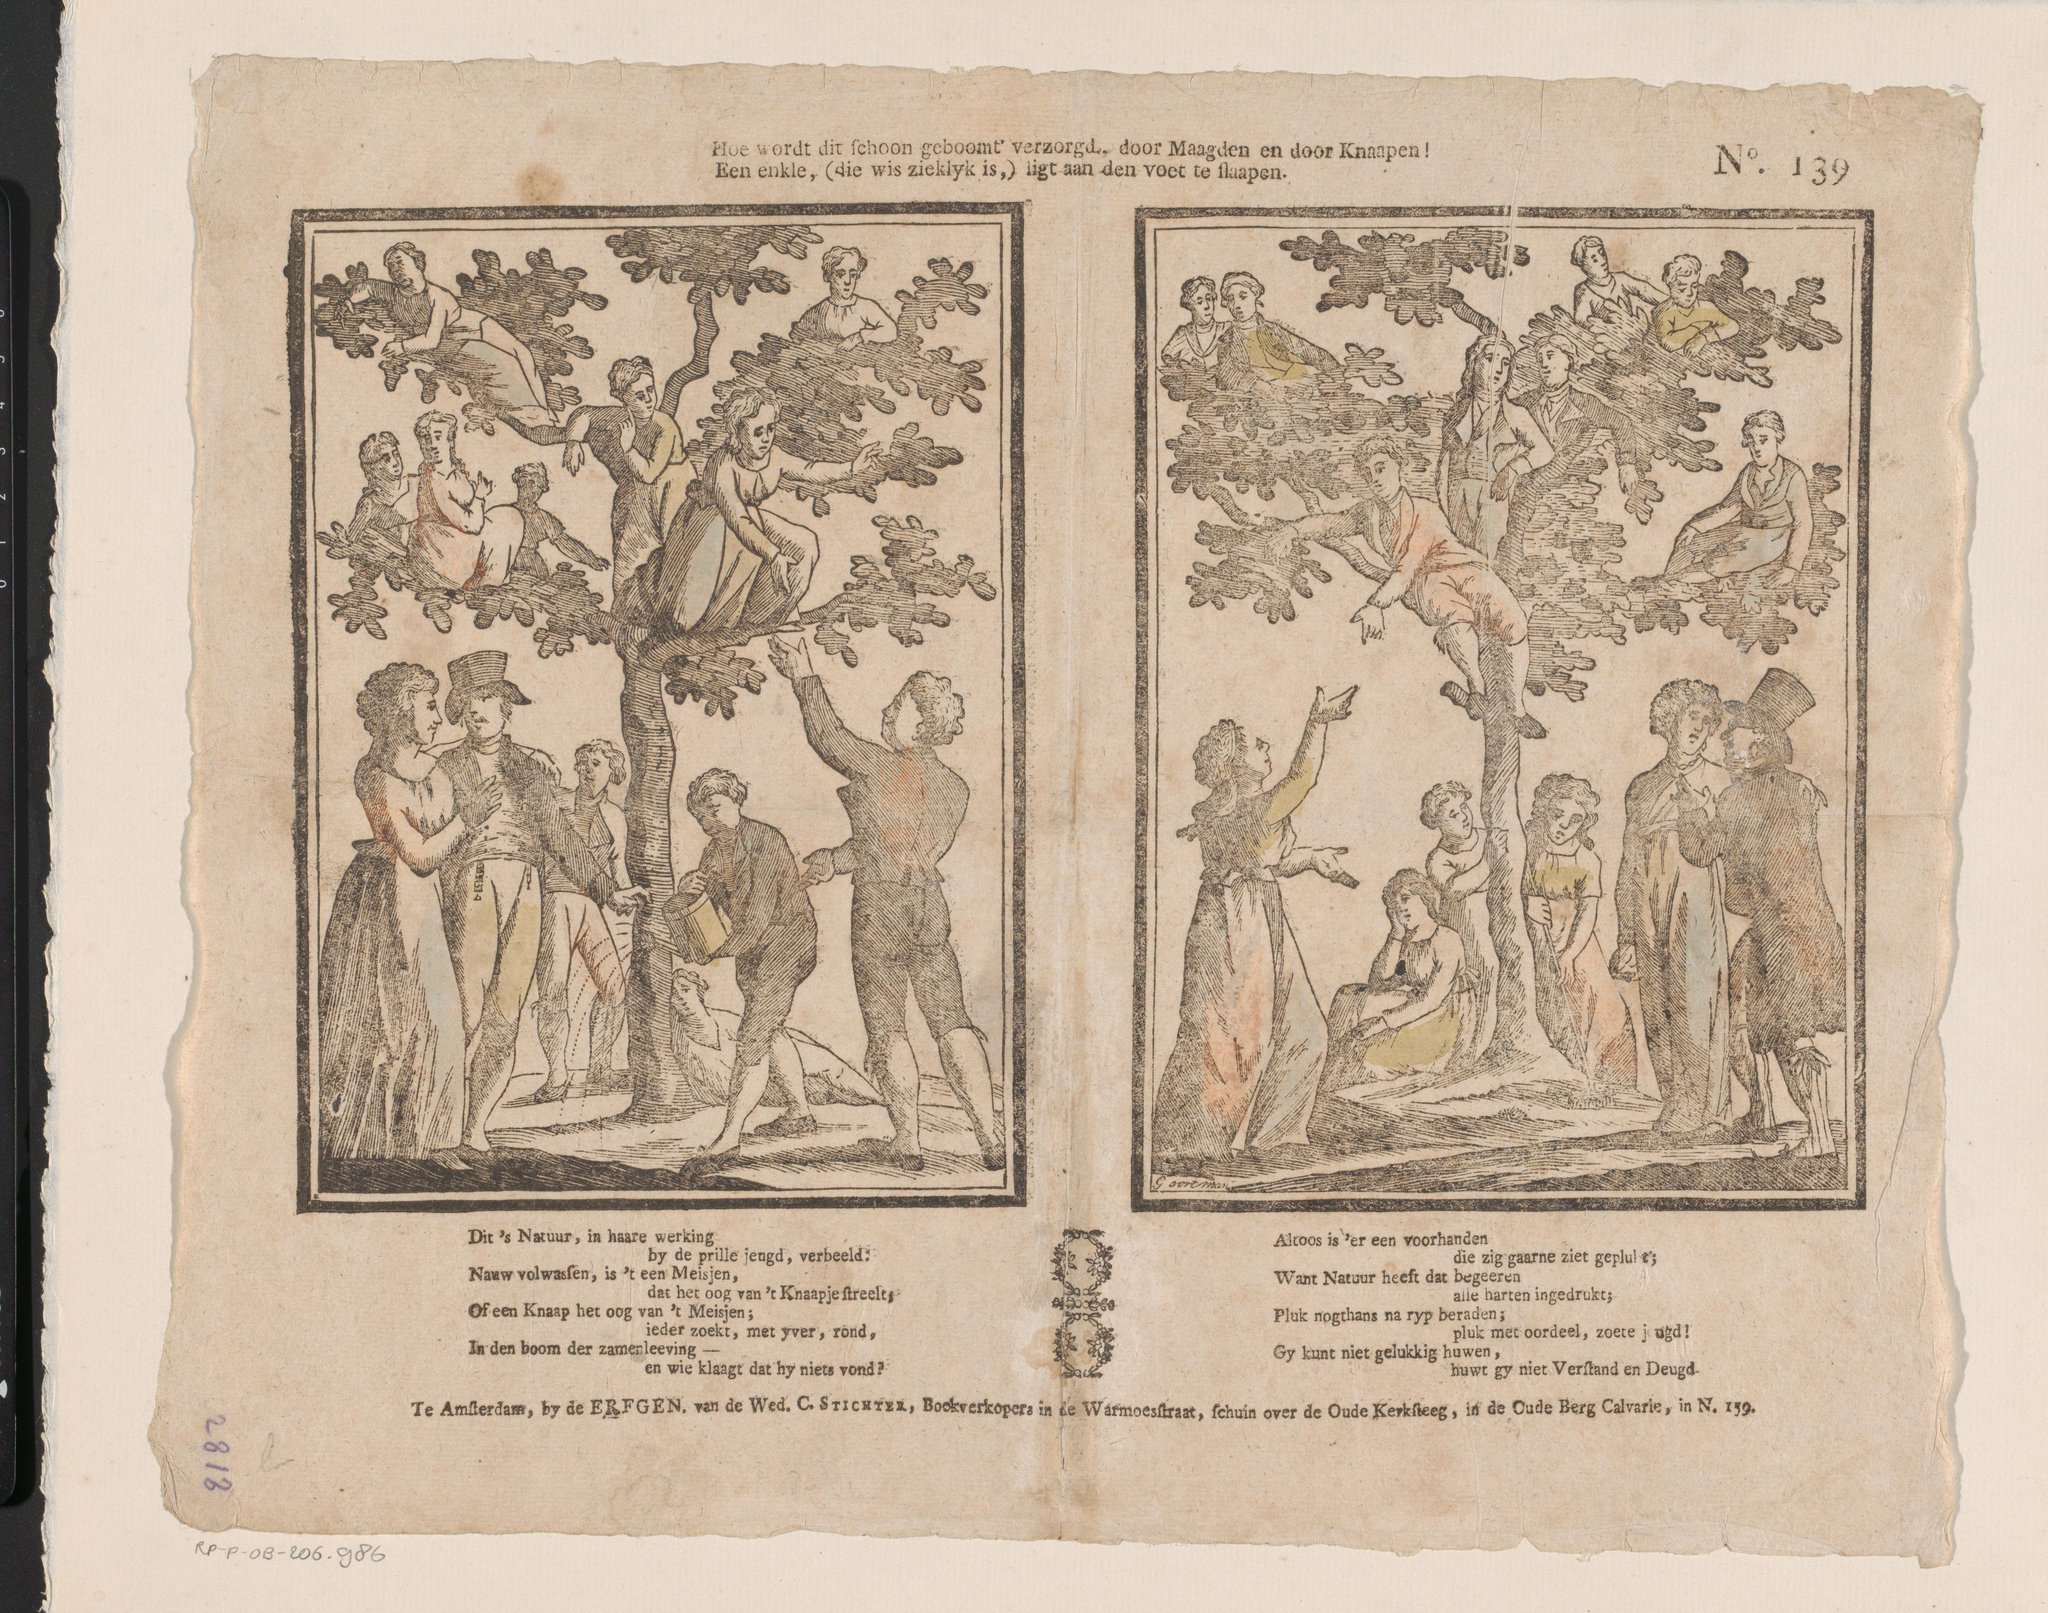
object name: popular print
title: Hoe wordt dit schoon geboomt' verzorgd, door maagden en door knapen! / Een enkle, (die wis zieklyk is,) ligt aan den voet te slapen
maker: gerrit oortman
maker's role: print maker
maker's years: 1781-1822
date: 1715-1813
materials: paper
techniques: colour, letterpress printing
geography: netherlands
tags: shaking lovers out of a tree, with cudgel - cc - pursuit of a man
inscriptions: inscription: ‘2313’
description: Blad met 2 voorstellingen van de vrijers- en vrijstersboom. Links: een boom vol vrouwen, waar mannen een vrijster kunnen uitzoeken. Rechts: een boom vol mannen, waar dames een potentiele vrijer kunnen "plukken". Onder elke afbeelding een achtregelig vers. Genummerd rechtsboven: No. 139.